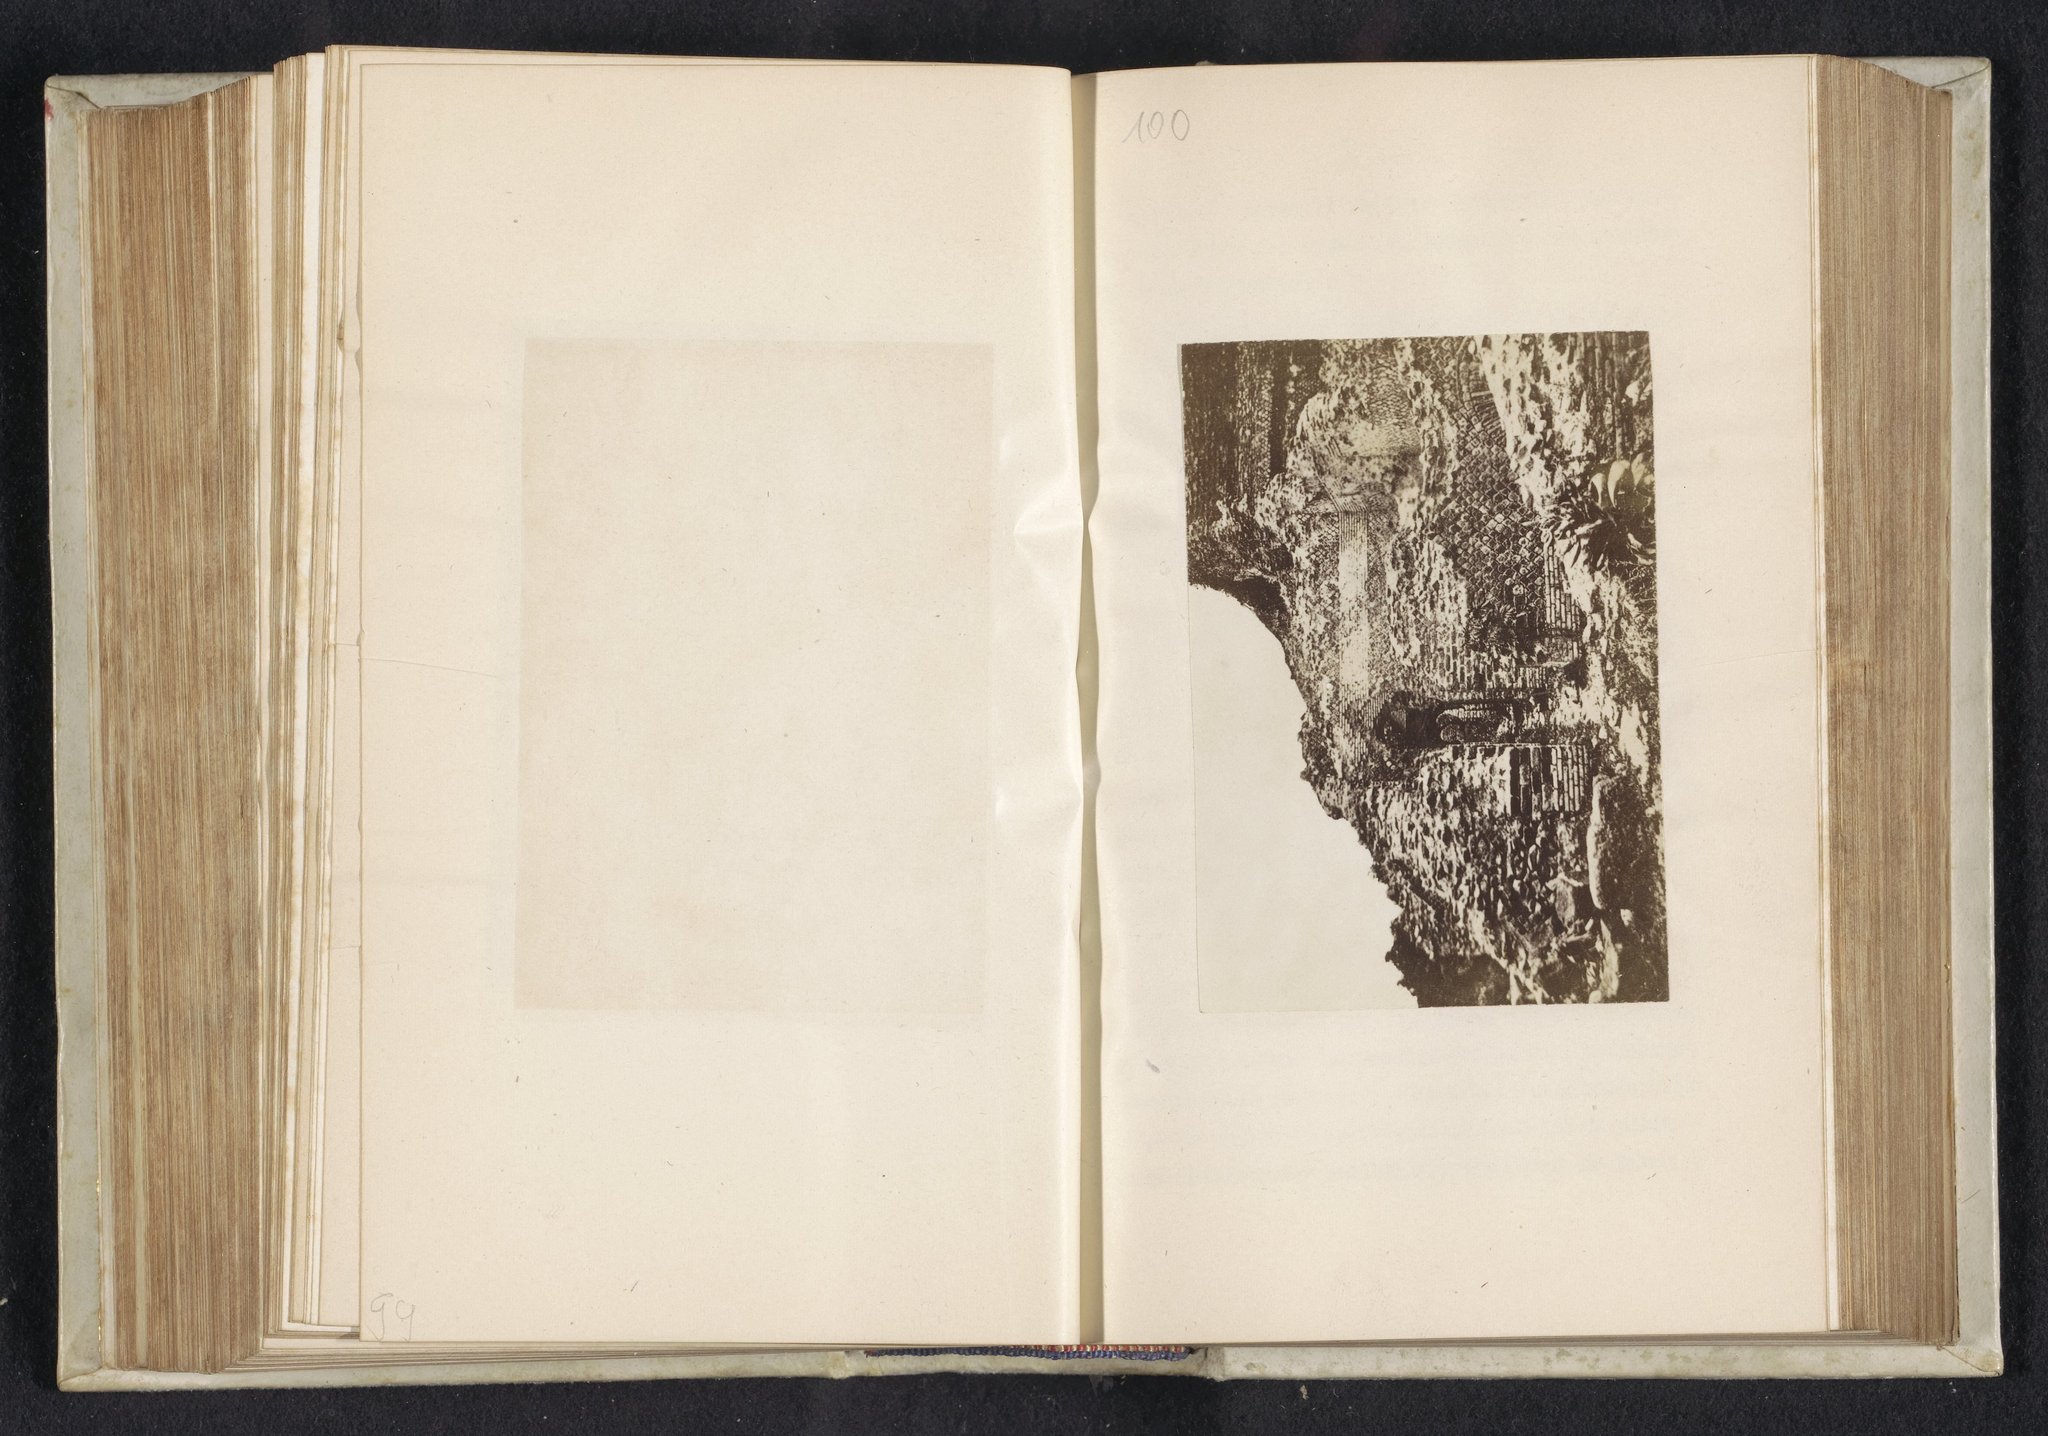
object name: page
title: Ruïne van (vermoedelijk) de Thermen van Caracalla te Rome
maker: Anonymous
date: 1850-1860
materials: photographic support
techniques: albumen print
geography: rome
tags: ruin of a building ~ architecture, public baths